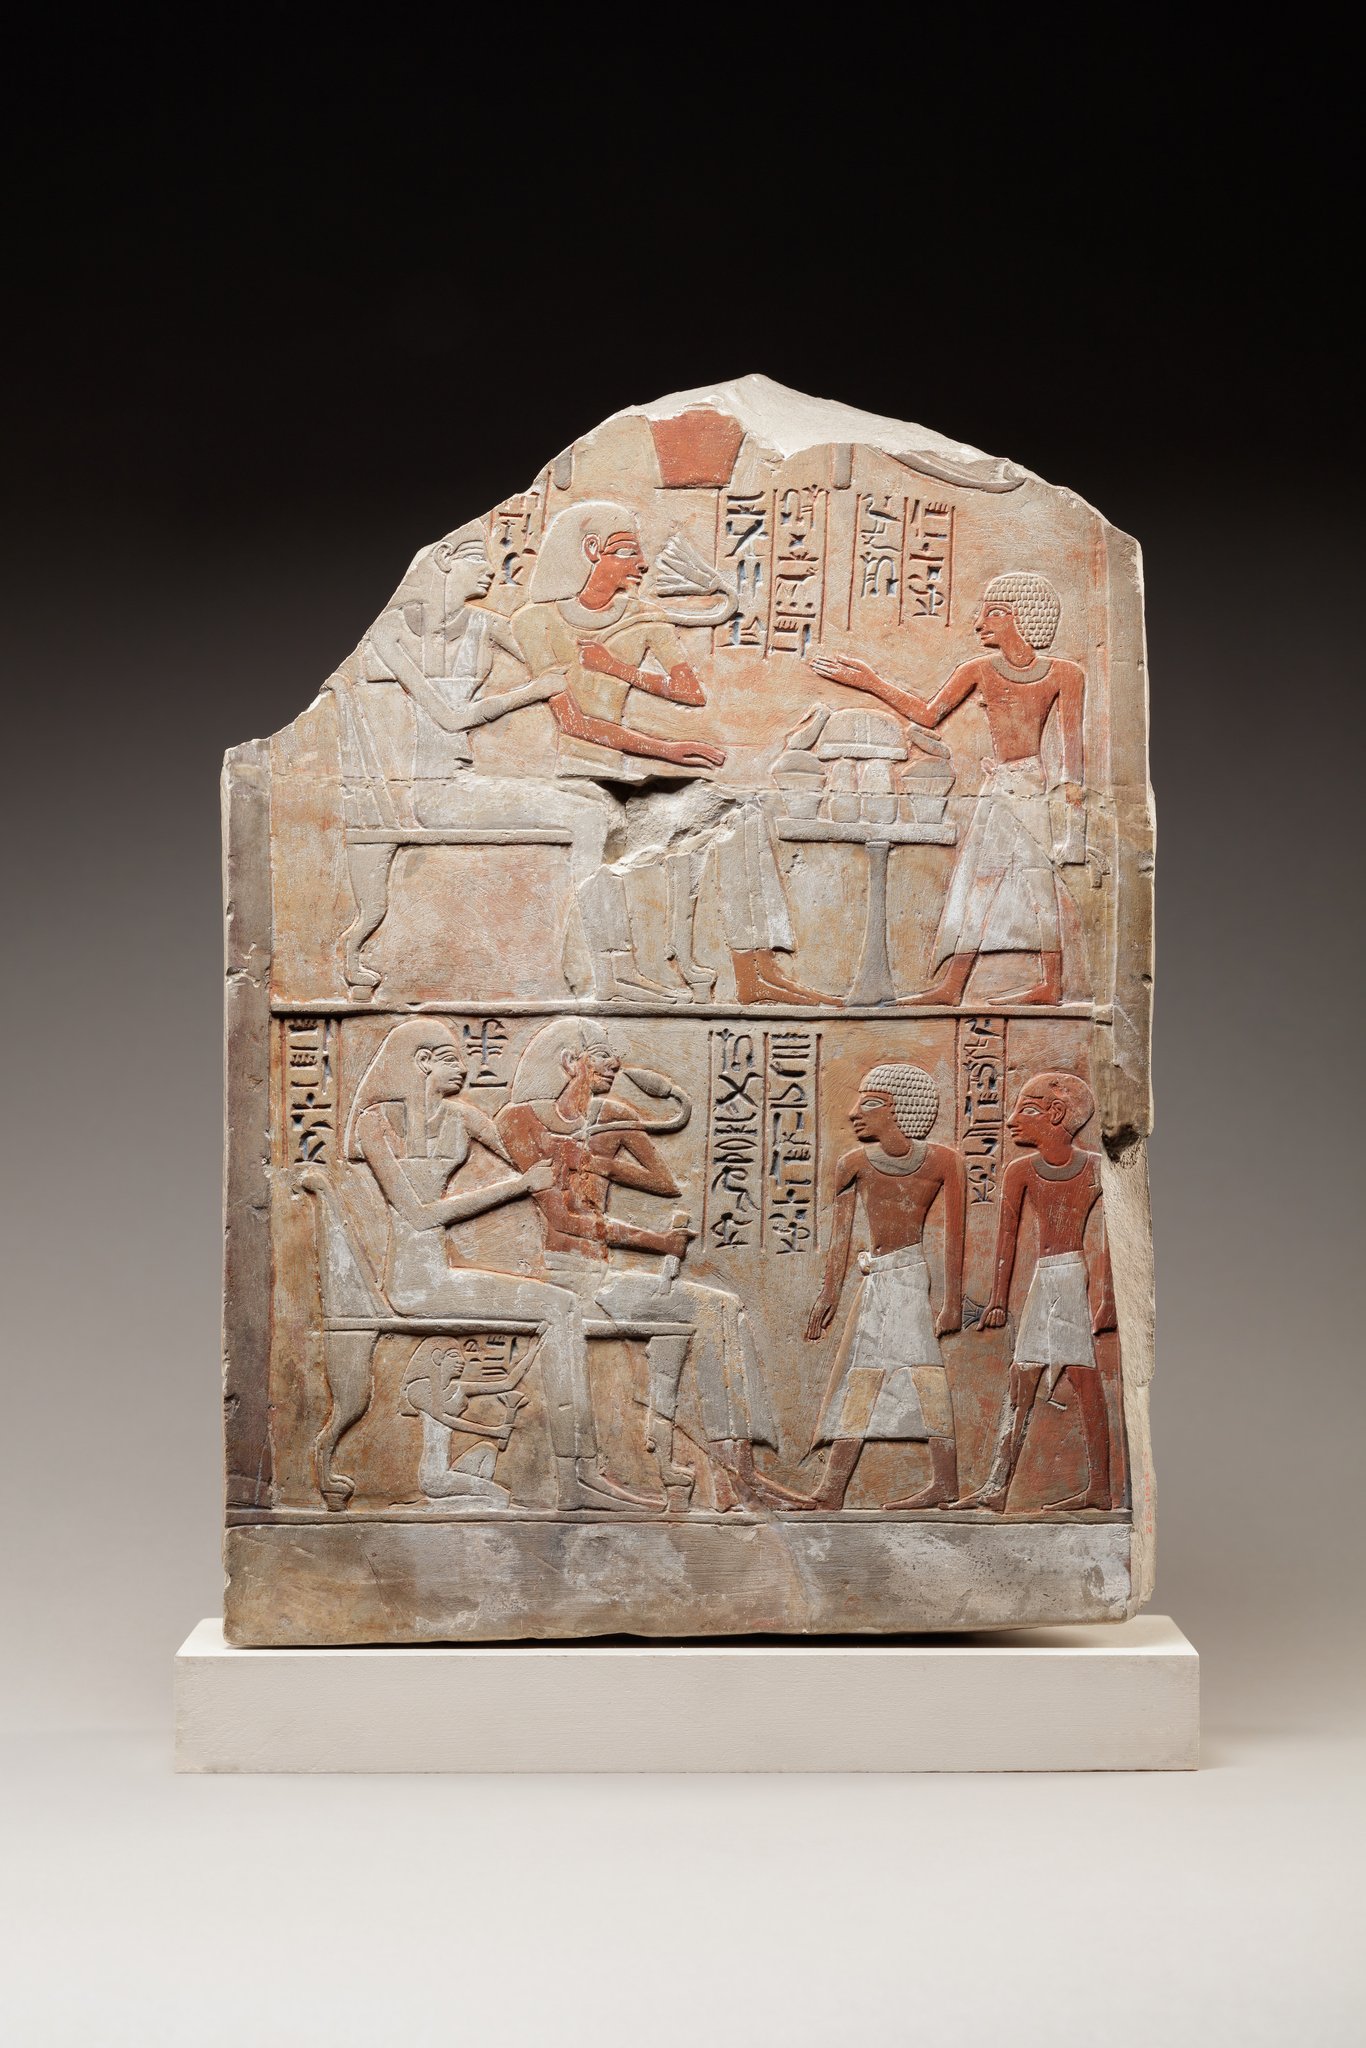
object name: stela, scribe amenhotep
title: Stela of the Scribe Amenhotep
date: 1550-1390 BCE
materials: limestone, pigment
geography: egypt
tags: men,women